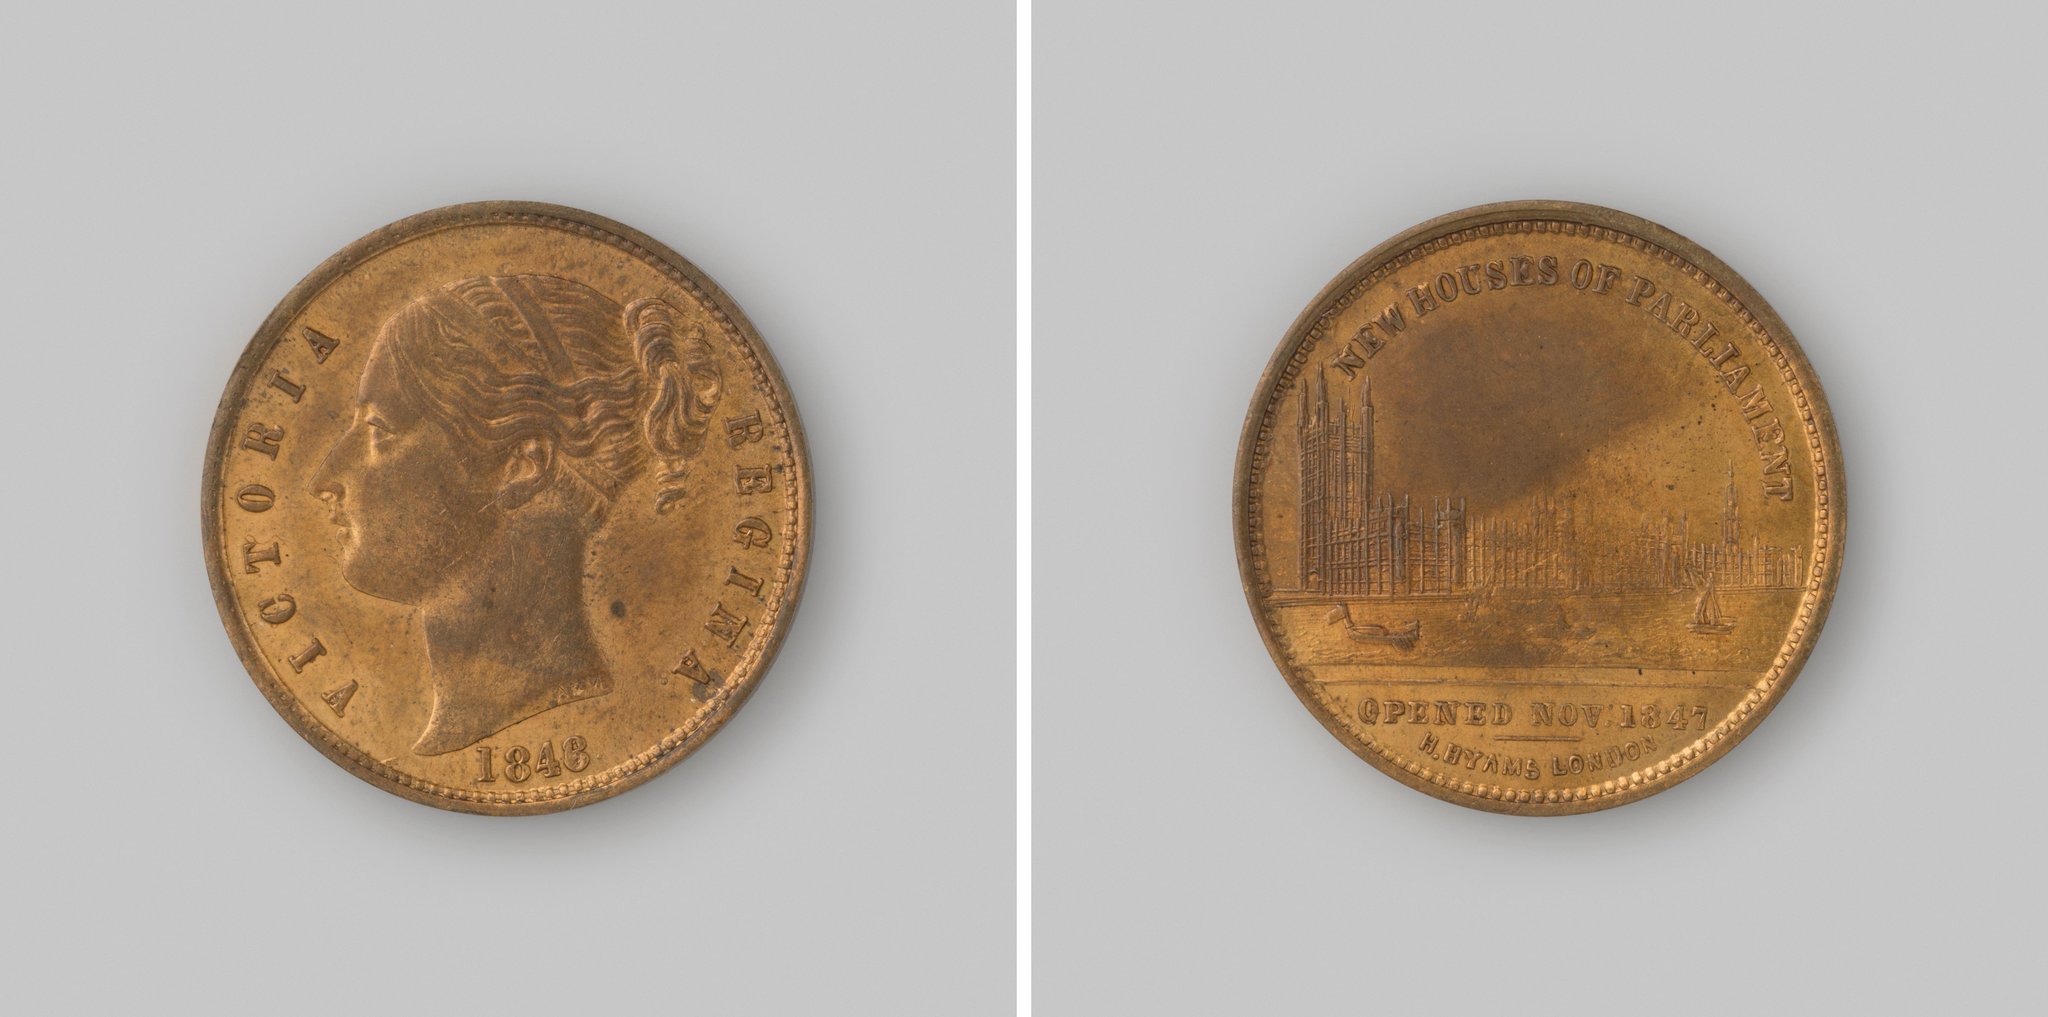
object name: history medal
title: Opening van de Parlementsgebouwen te Londen 1847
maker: h. hyams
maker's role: die cutter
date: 1847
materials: brass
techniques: striking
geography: london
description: Vergulde pennig, op de voorzijde het portret van Koningin Victoria naar links met omschrift, op de keerzijde het aanzicht van de Parlementsgebouwen met omschrift en afsnedetekst.